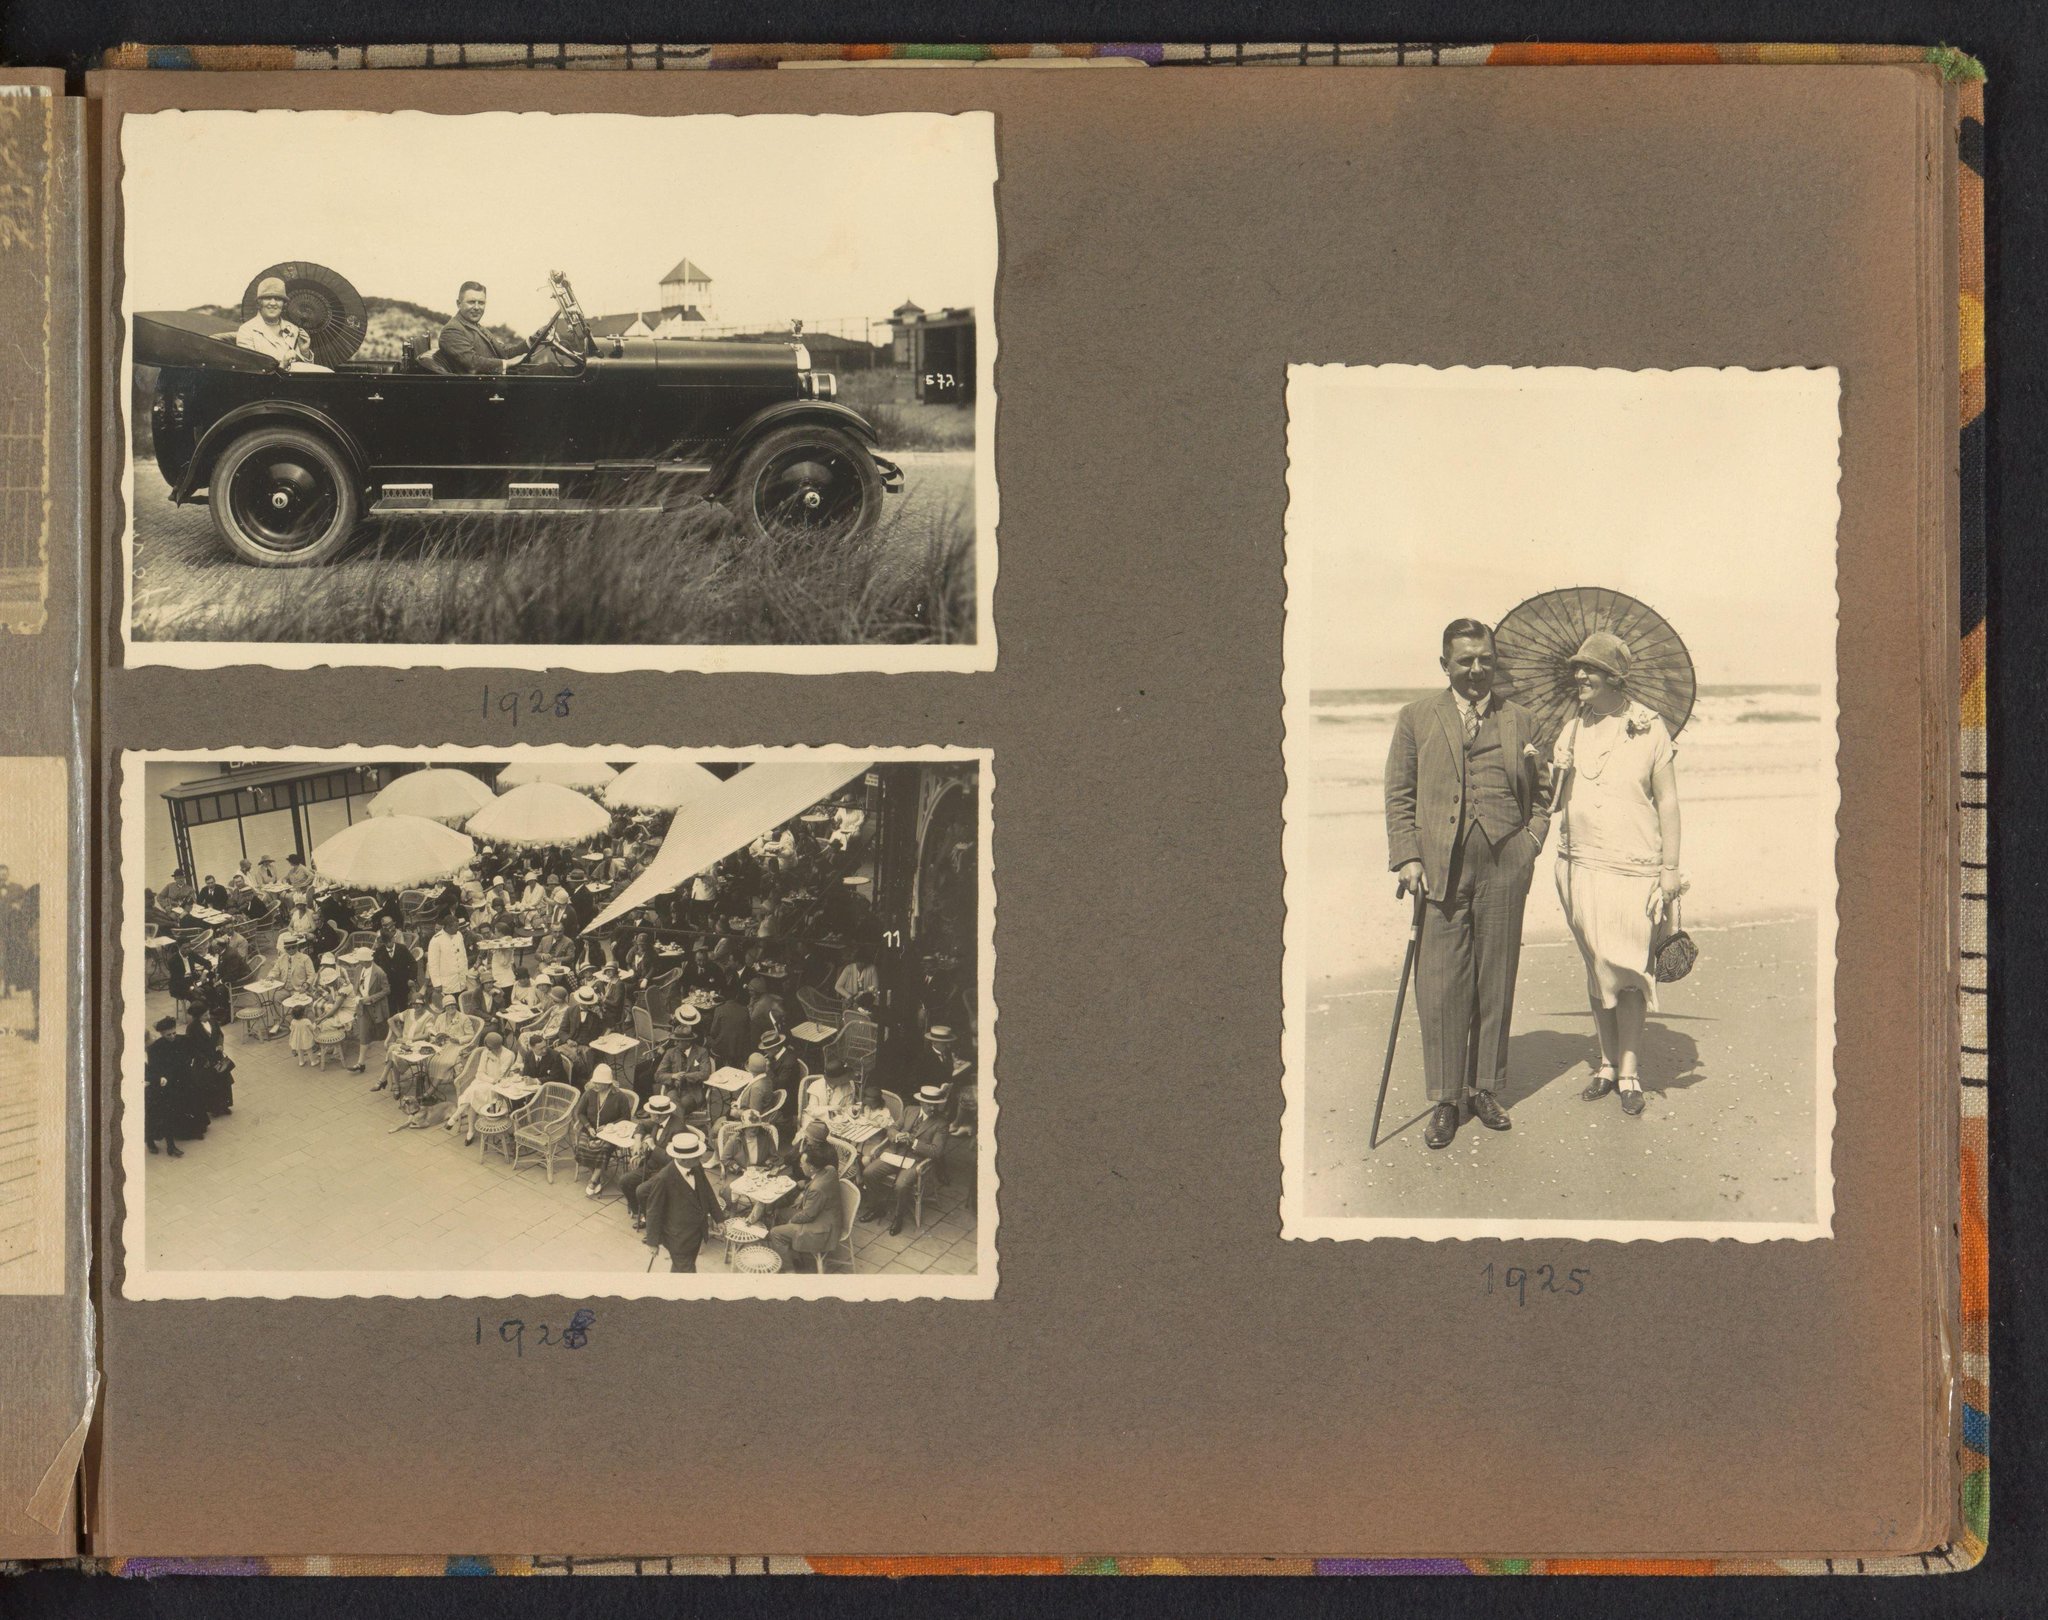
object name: photograph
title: Strandtaferelen en auto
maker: Anonymous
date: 1925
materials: cardboard, photographic support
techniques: gelatin silver print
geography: scheveningen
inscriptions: number: ‘572’, number: ‘11’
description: Albumblad met foto's van een stel in een auto in de duinen, van gasten op het terras van 'Café-Restaurant du Boulevard' in Scheveningen en van een stel op het strand. Onderdeel van Fotoalbum van een onbekende Nederlandse familie met connecties in Suriname en Nederlands-Indië (2).